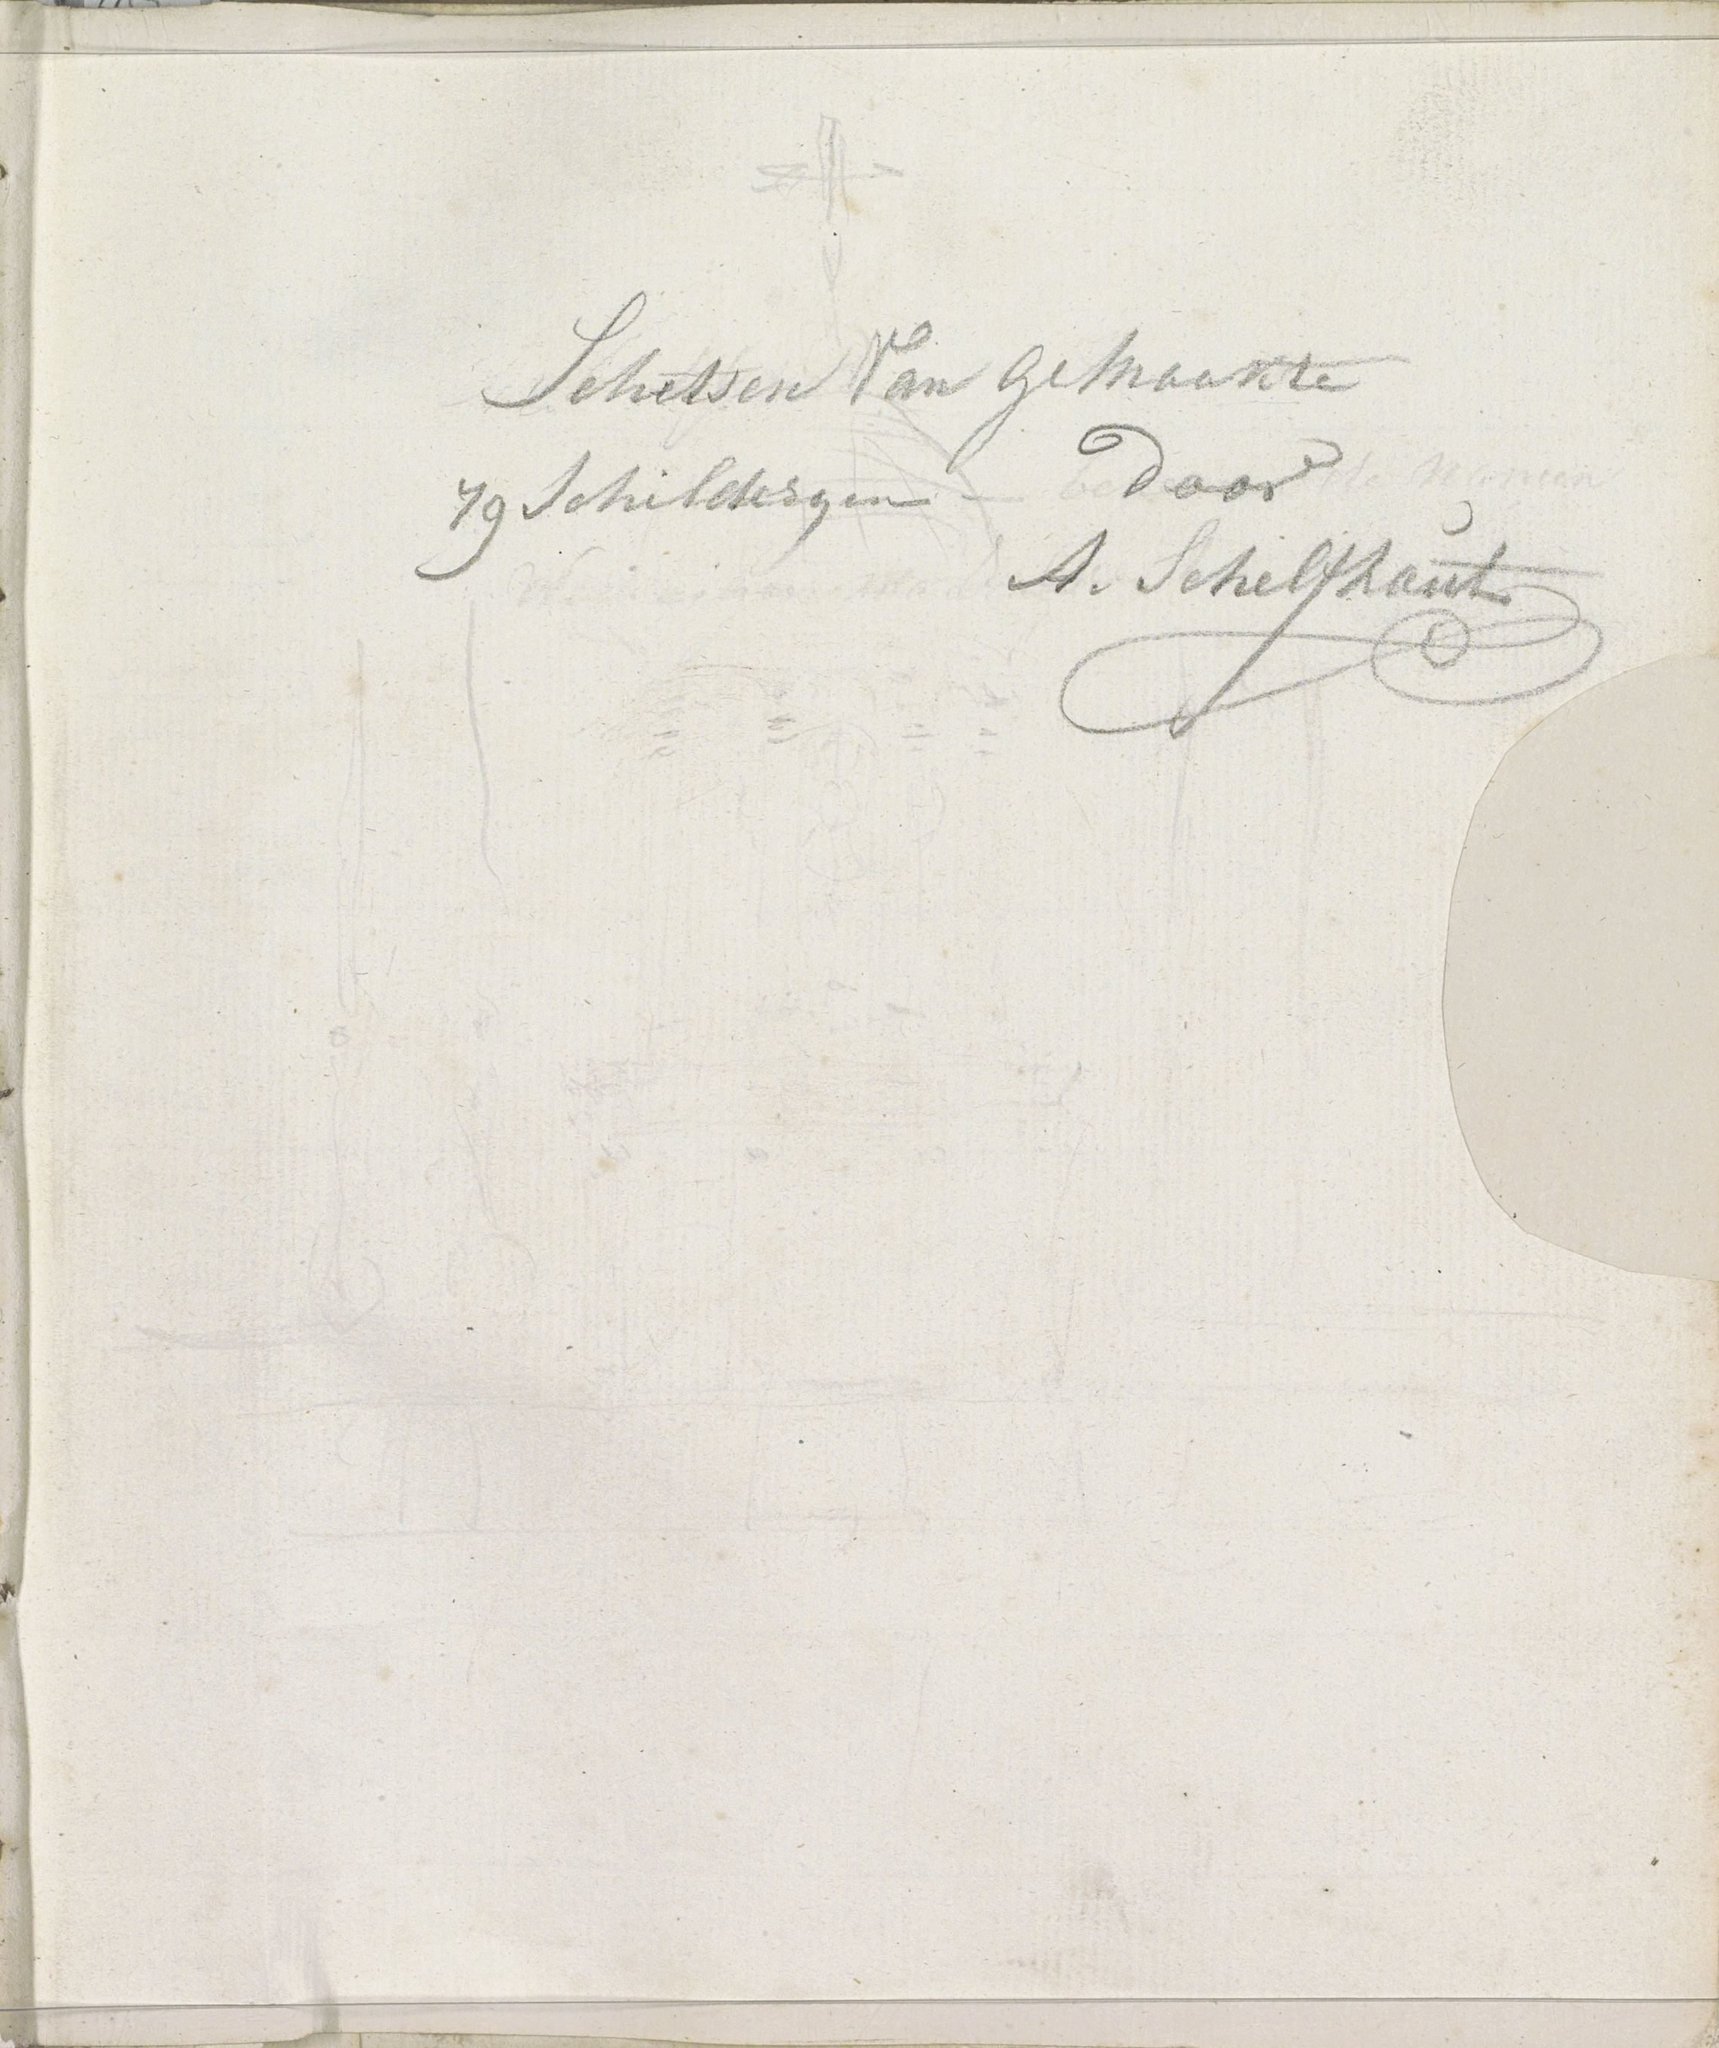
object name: sketchbook leaf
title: Notitie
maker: andreas schelfhout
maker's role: draughtsman, painter, print maker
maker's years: 1787-1870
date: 1825-1829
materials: paper, pencil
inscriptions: annotation: ‘Schetsen van gemaakte/ 79 schilderijen door/ A. Schelfhout’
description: Blad 3 recto uit een schetsboek met 95 bladen.